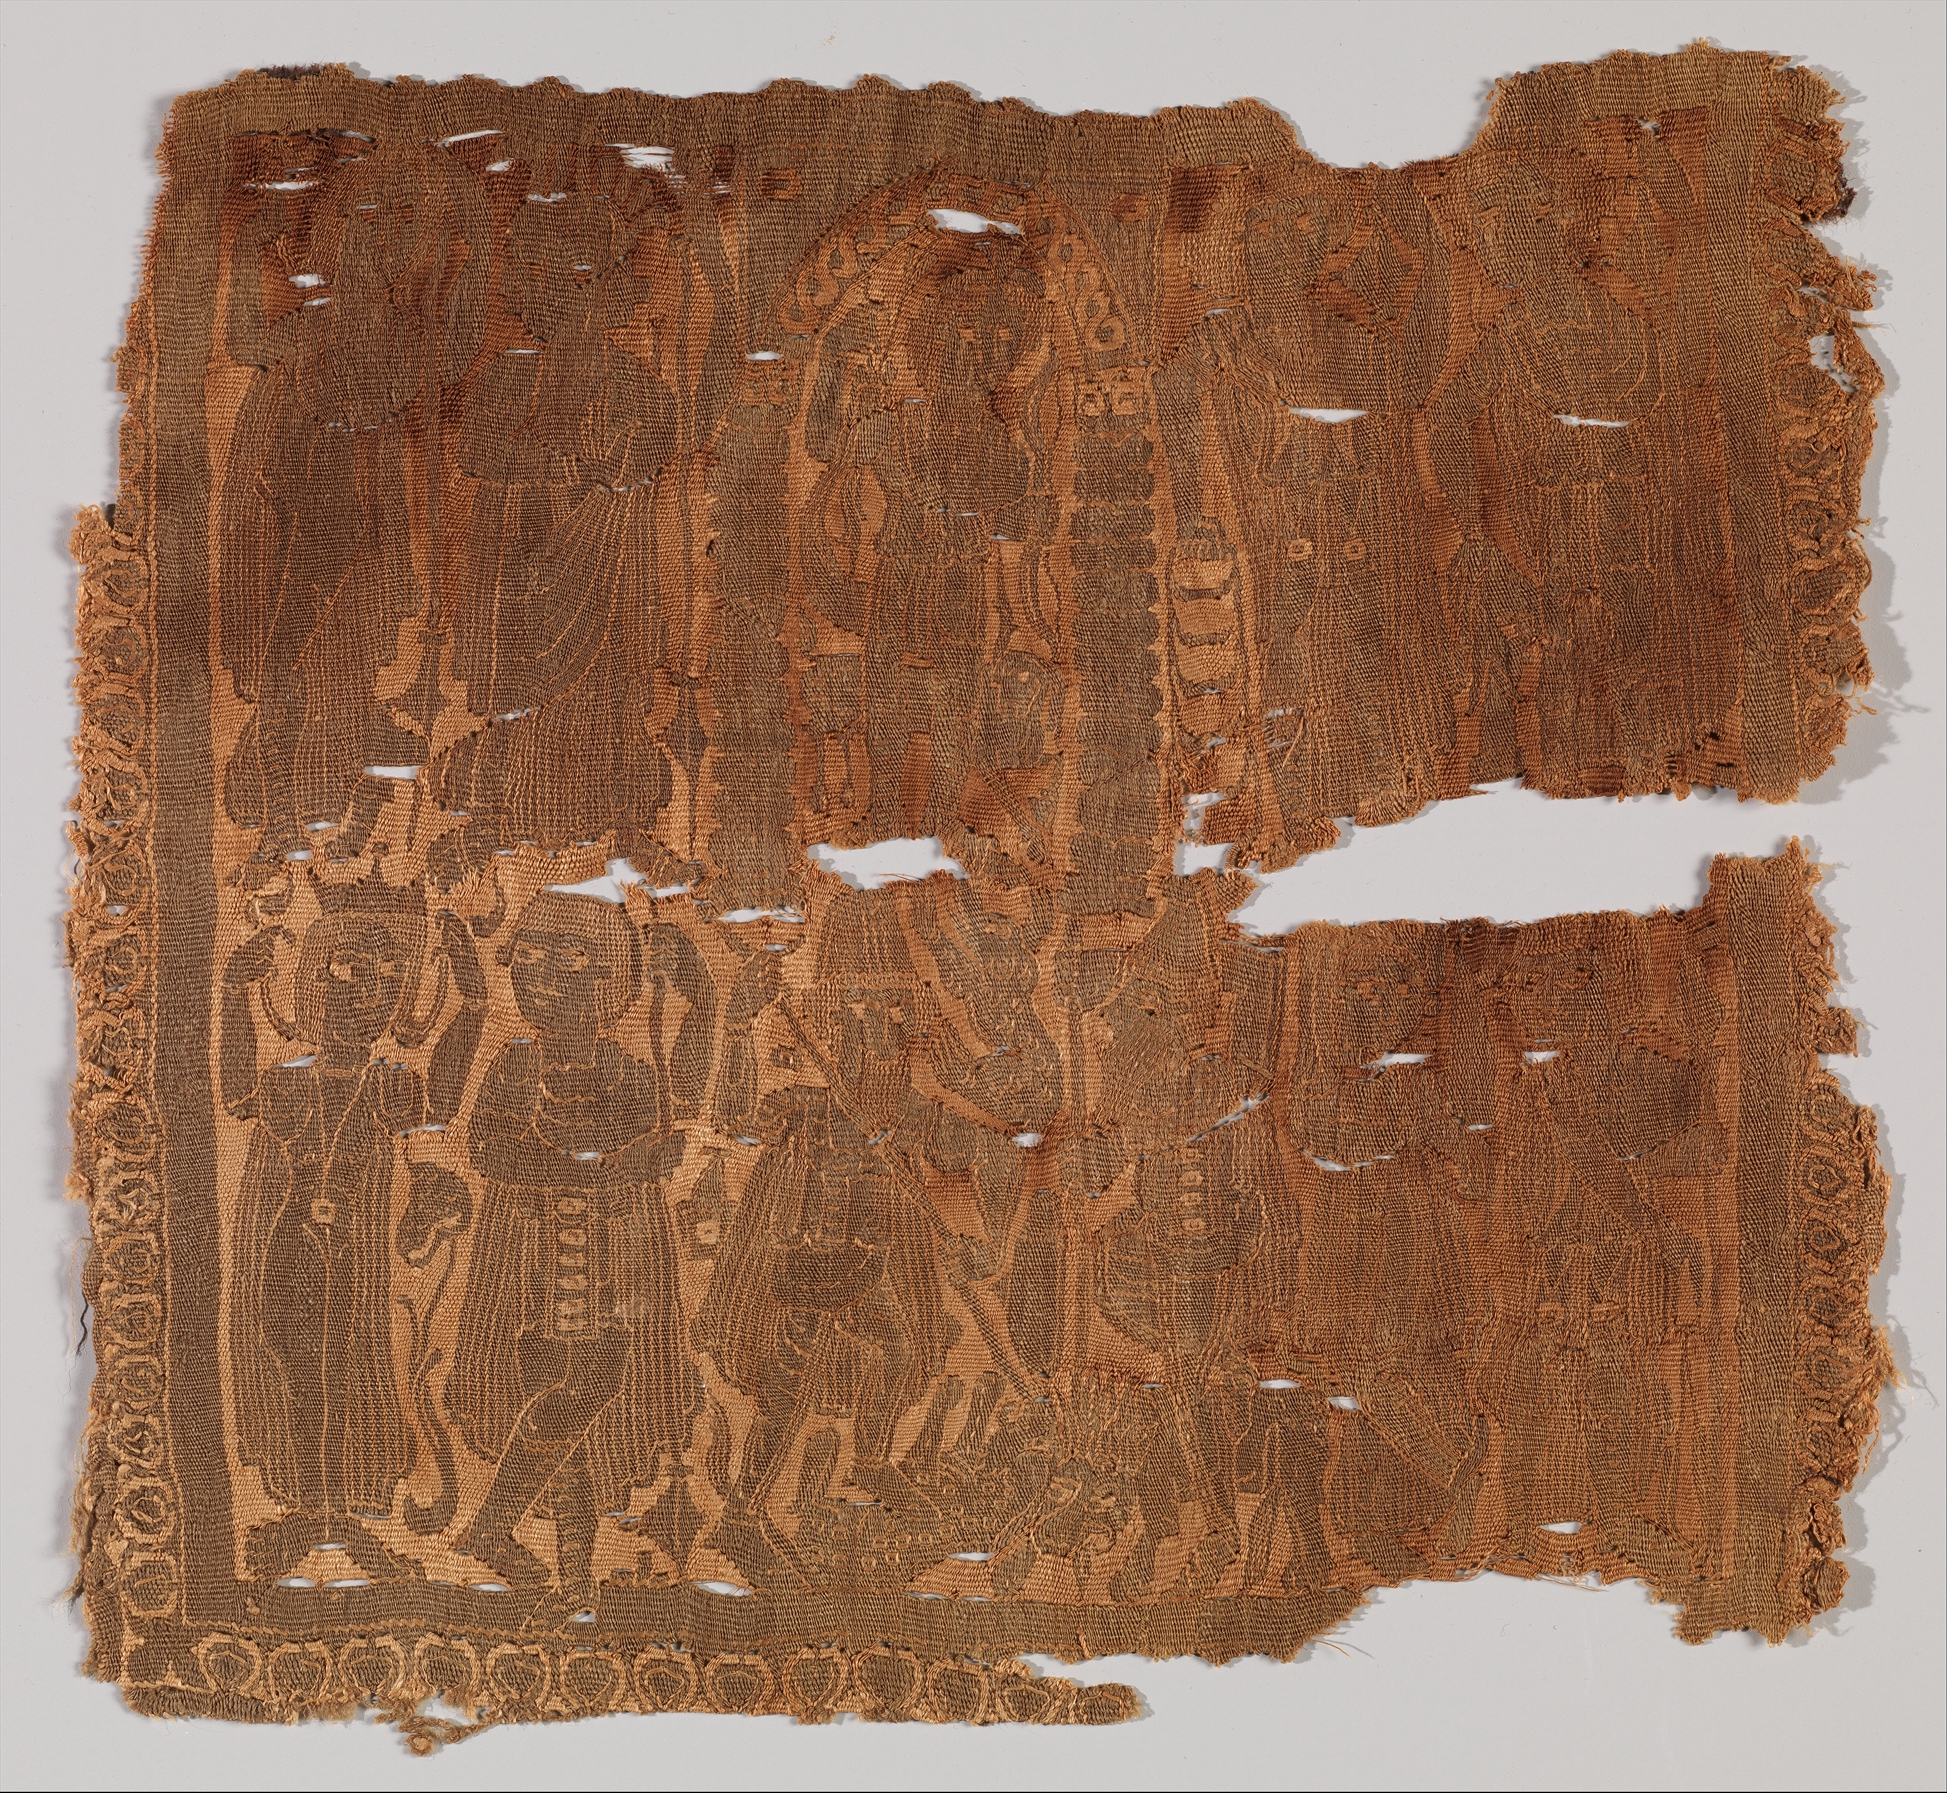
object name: textile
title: Square with Classical Scenes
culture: byzantine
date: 300-600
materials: linen, wool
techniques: weave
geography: egypt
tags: human figures